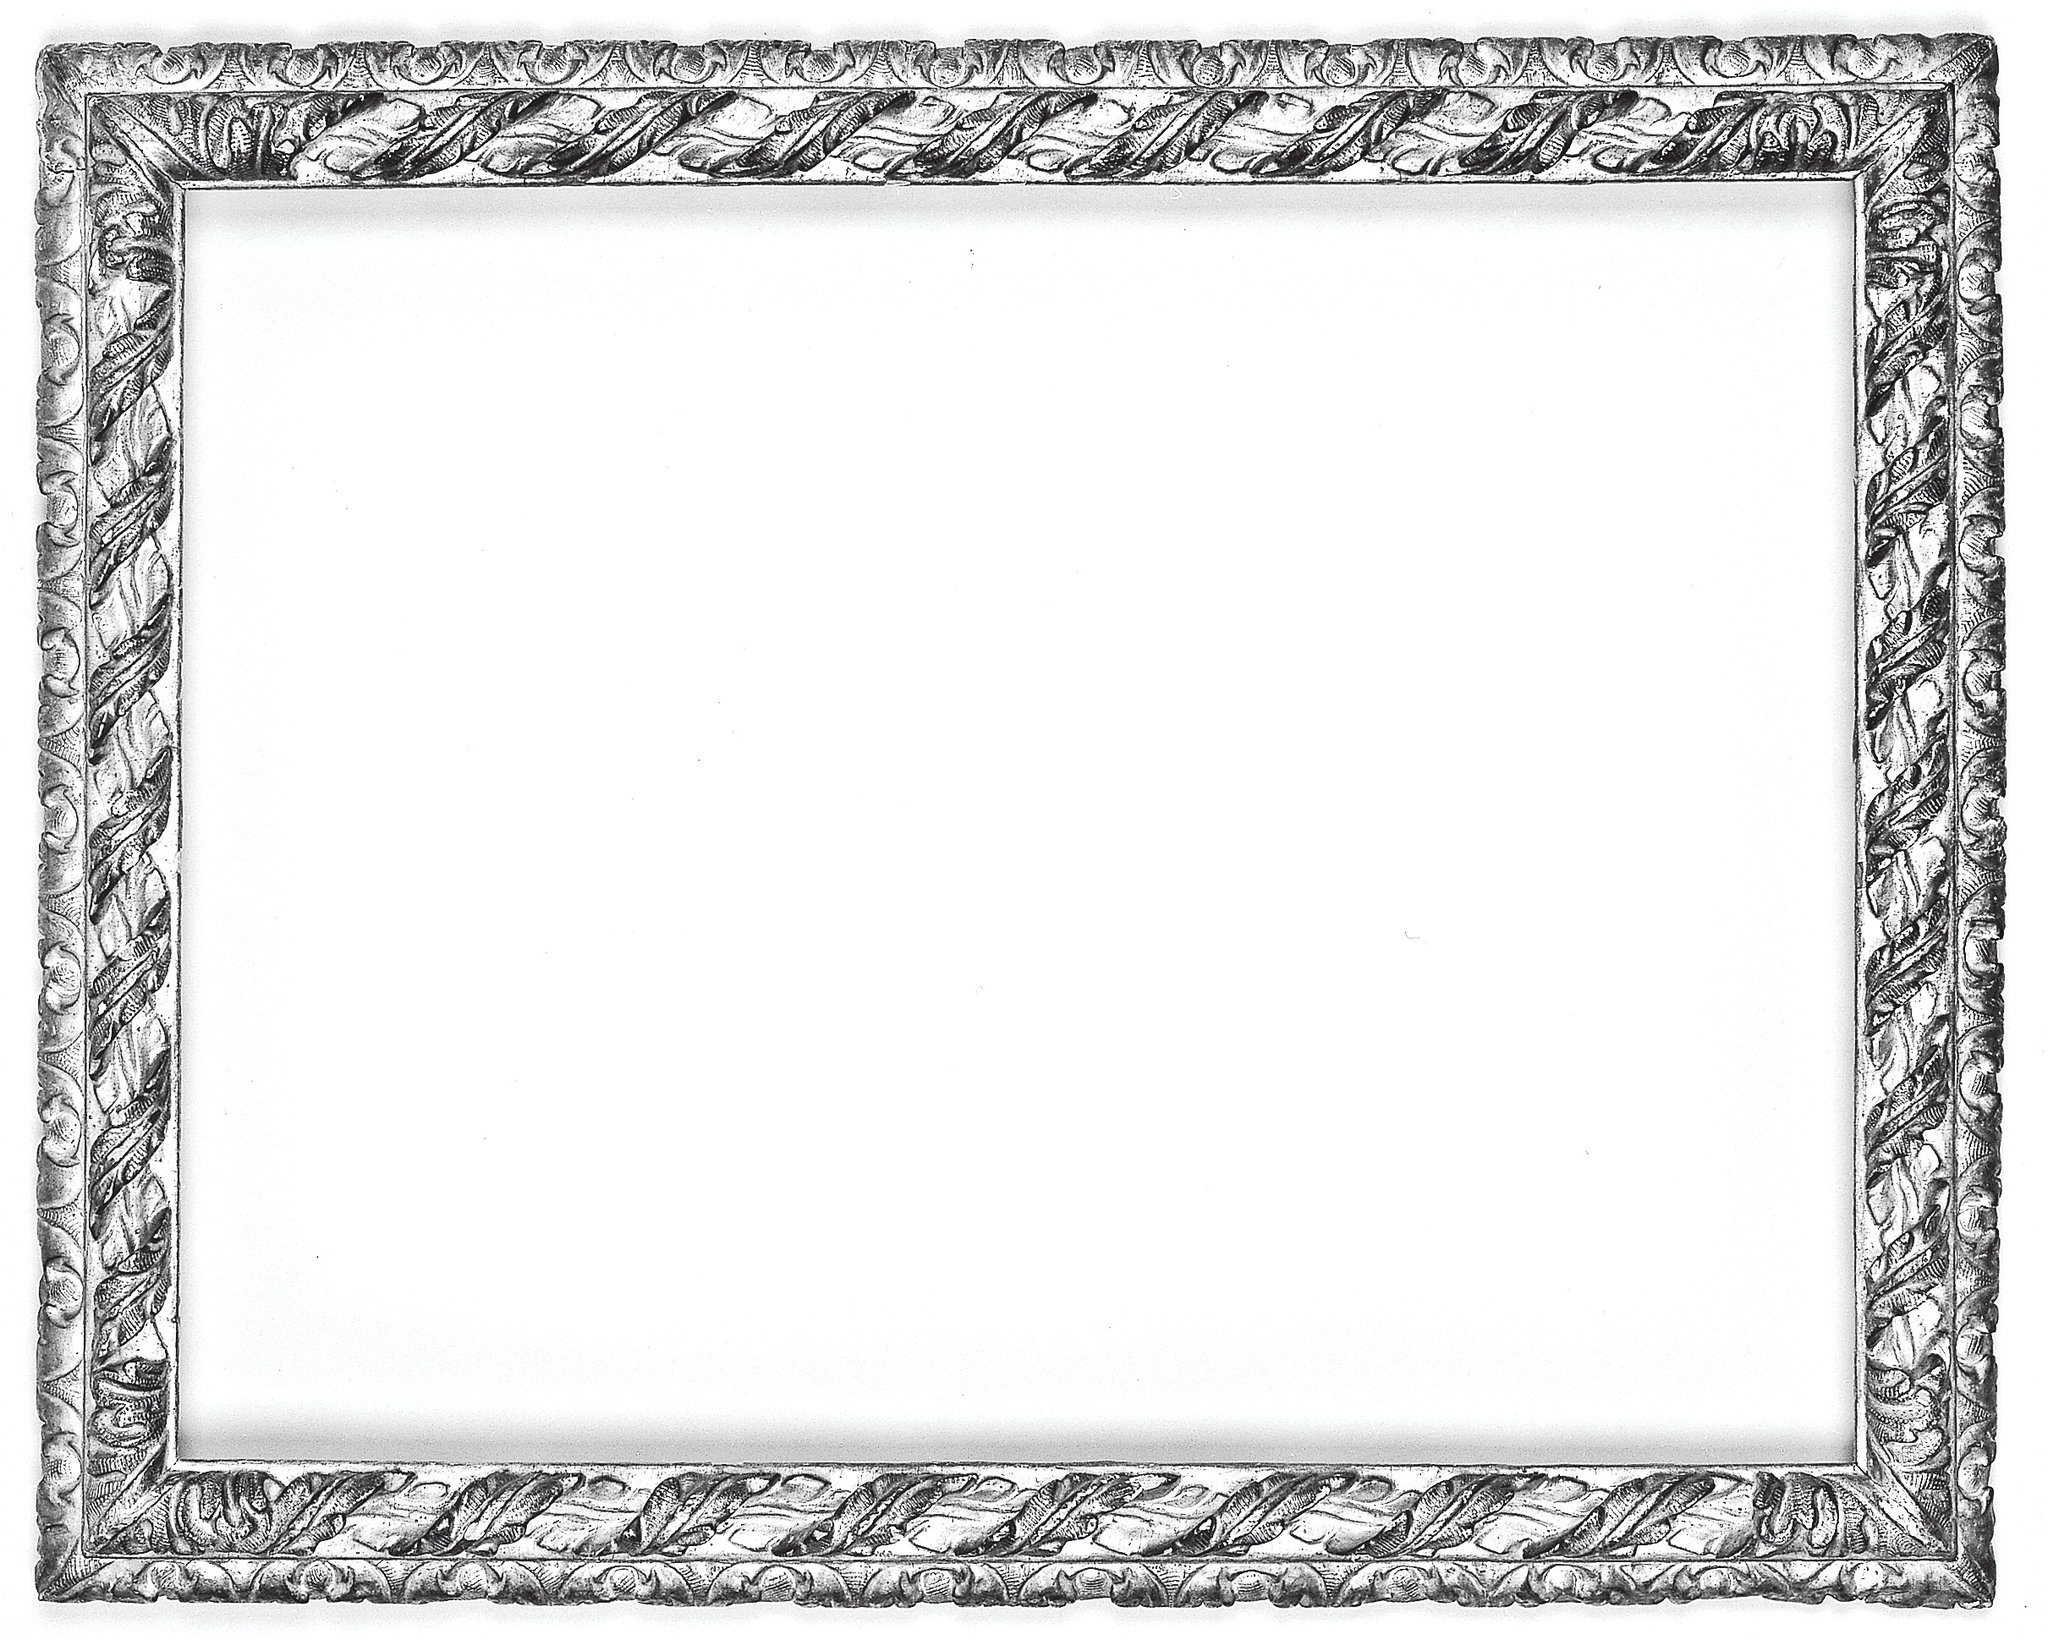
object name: frame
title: Rococo mirror frame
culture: italian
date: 1567-1600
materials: wood